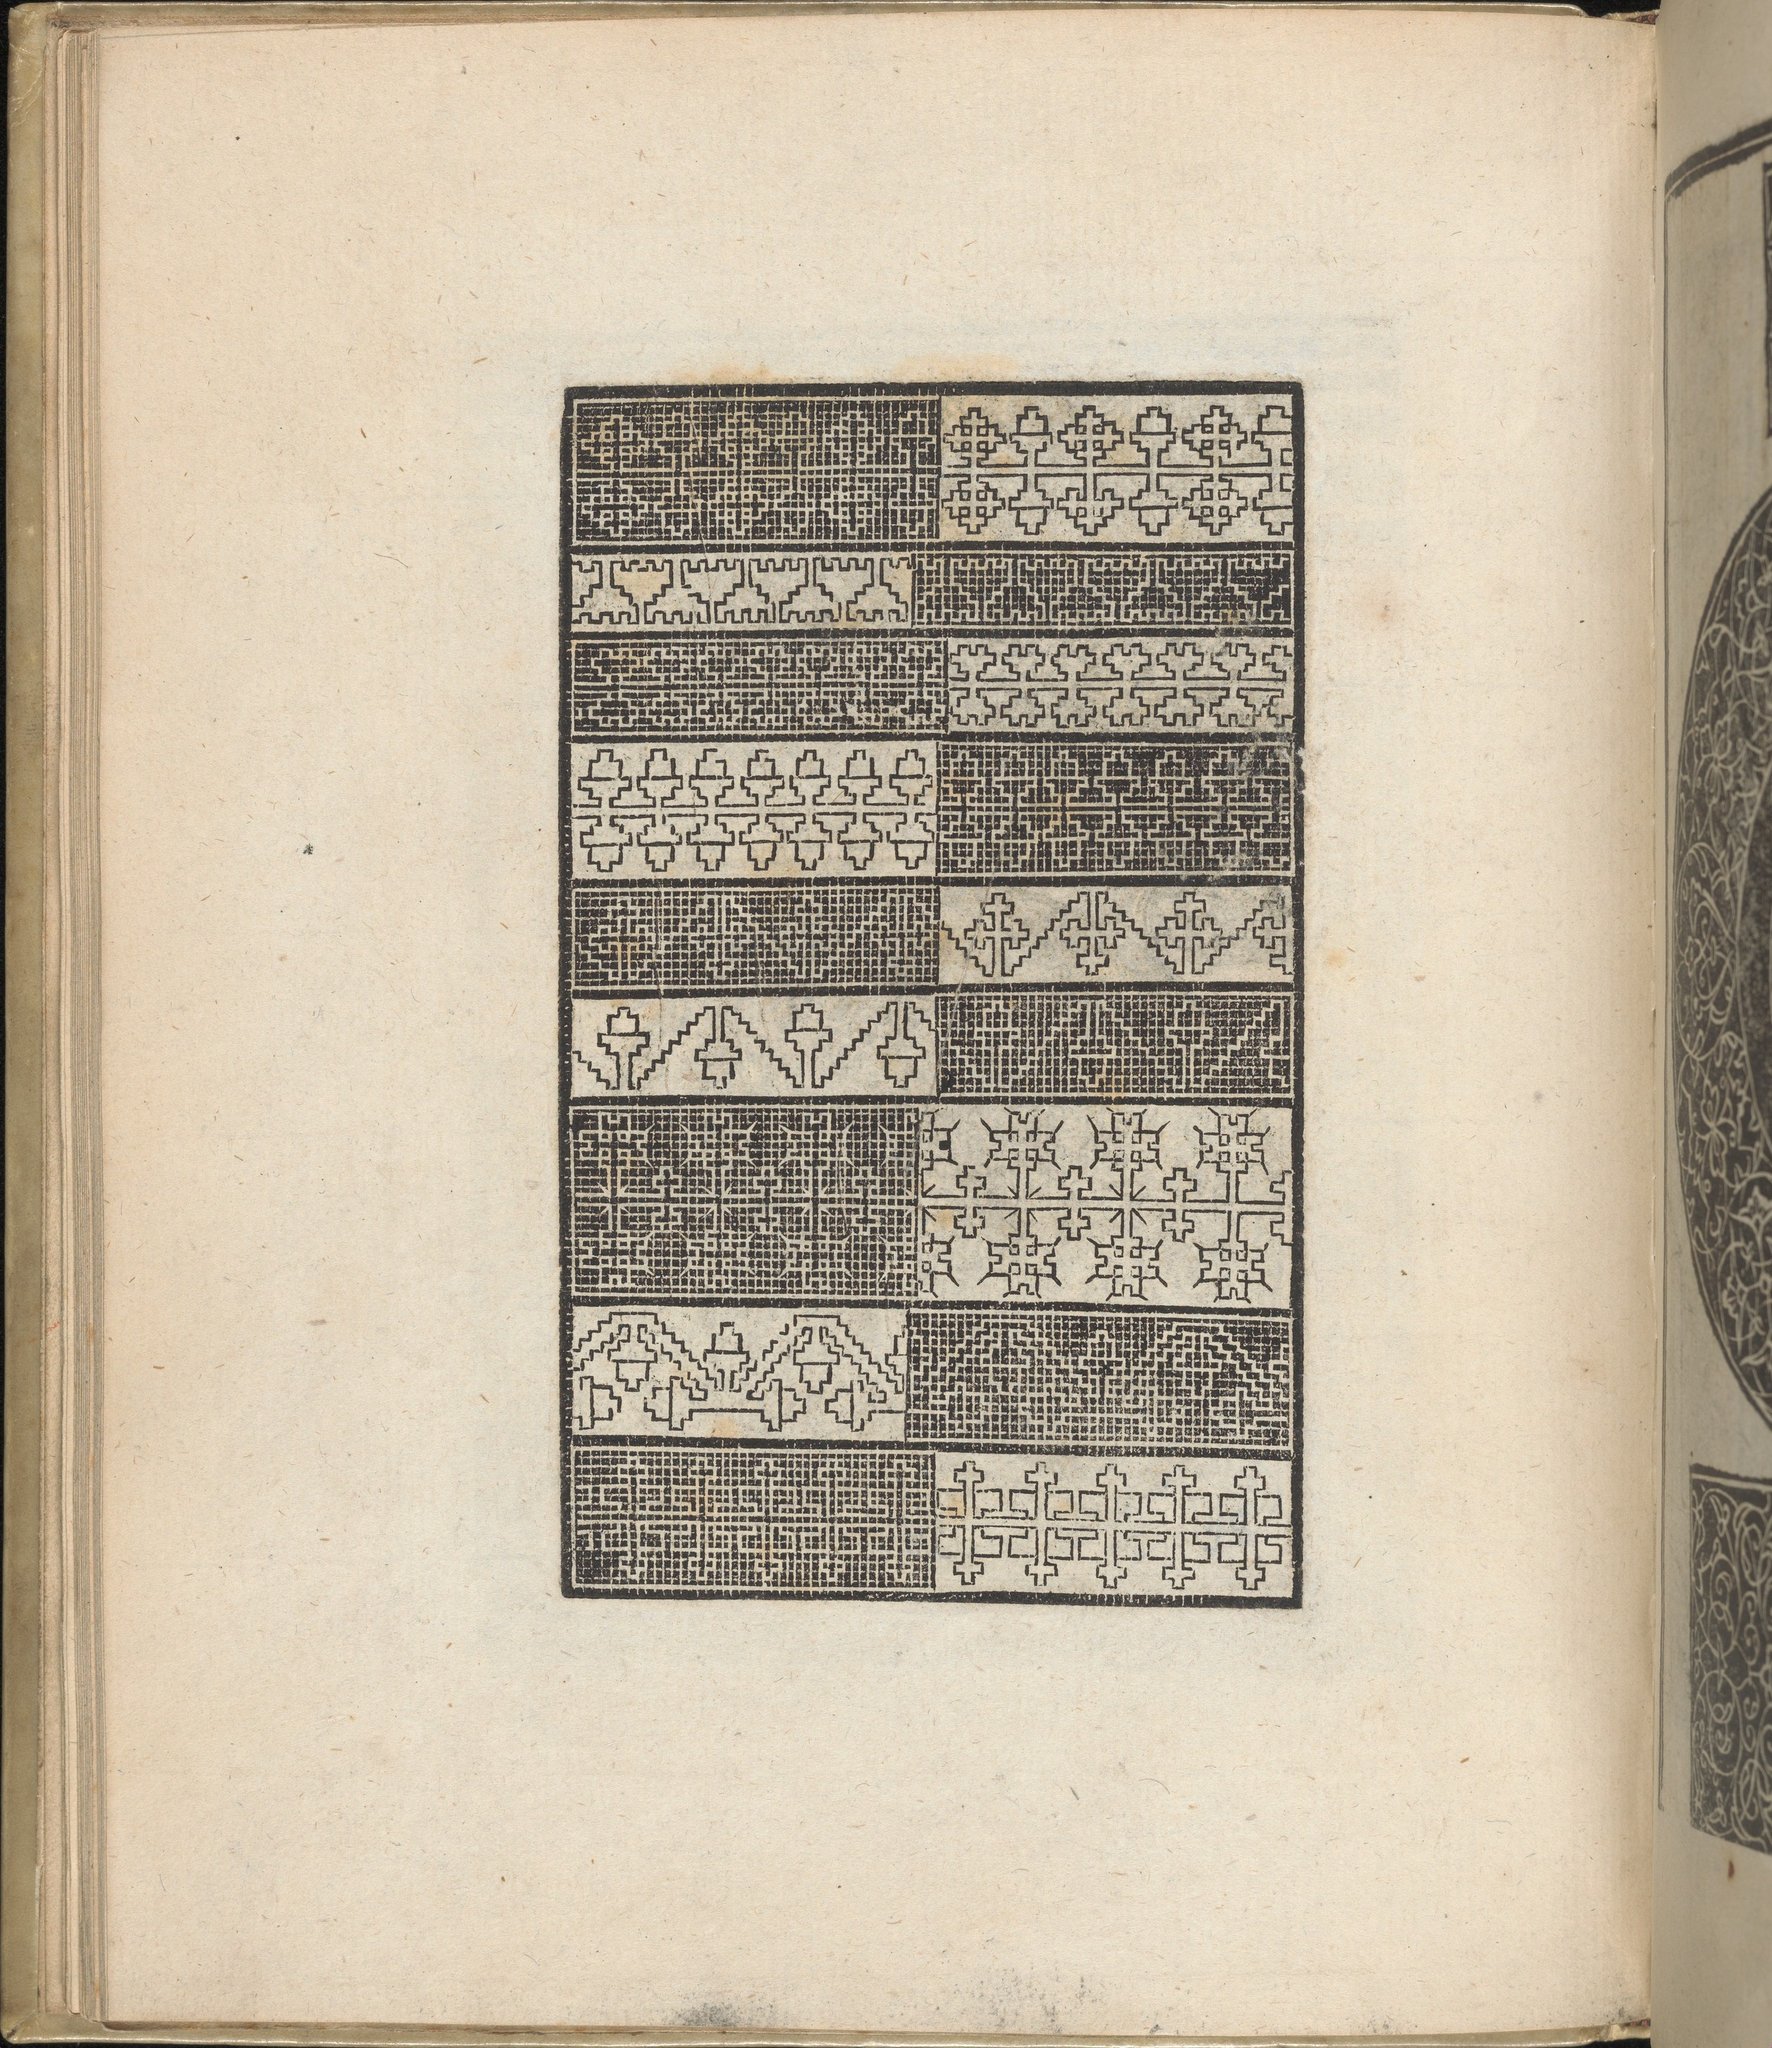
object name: book print ornament architecture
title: Trionfo Di Virtu. Libro Novo..., page 20 (recto)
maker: matteo pagano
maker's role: publisher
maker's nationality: italian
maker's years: 1515-1588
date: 1563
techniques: woodcut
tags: ornament